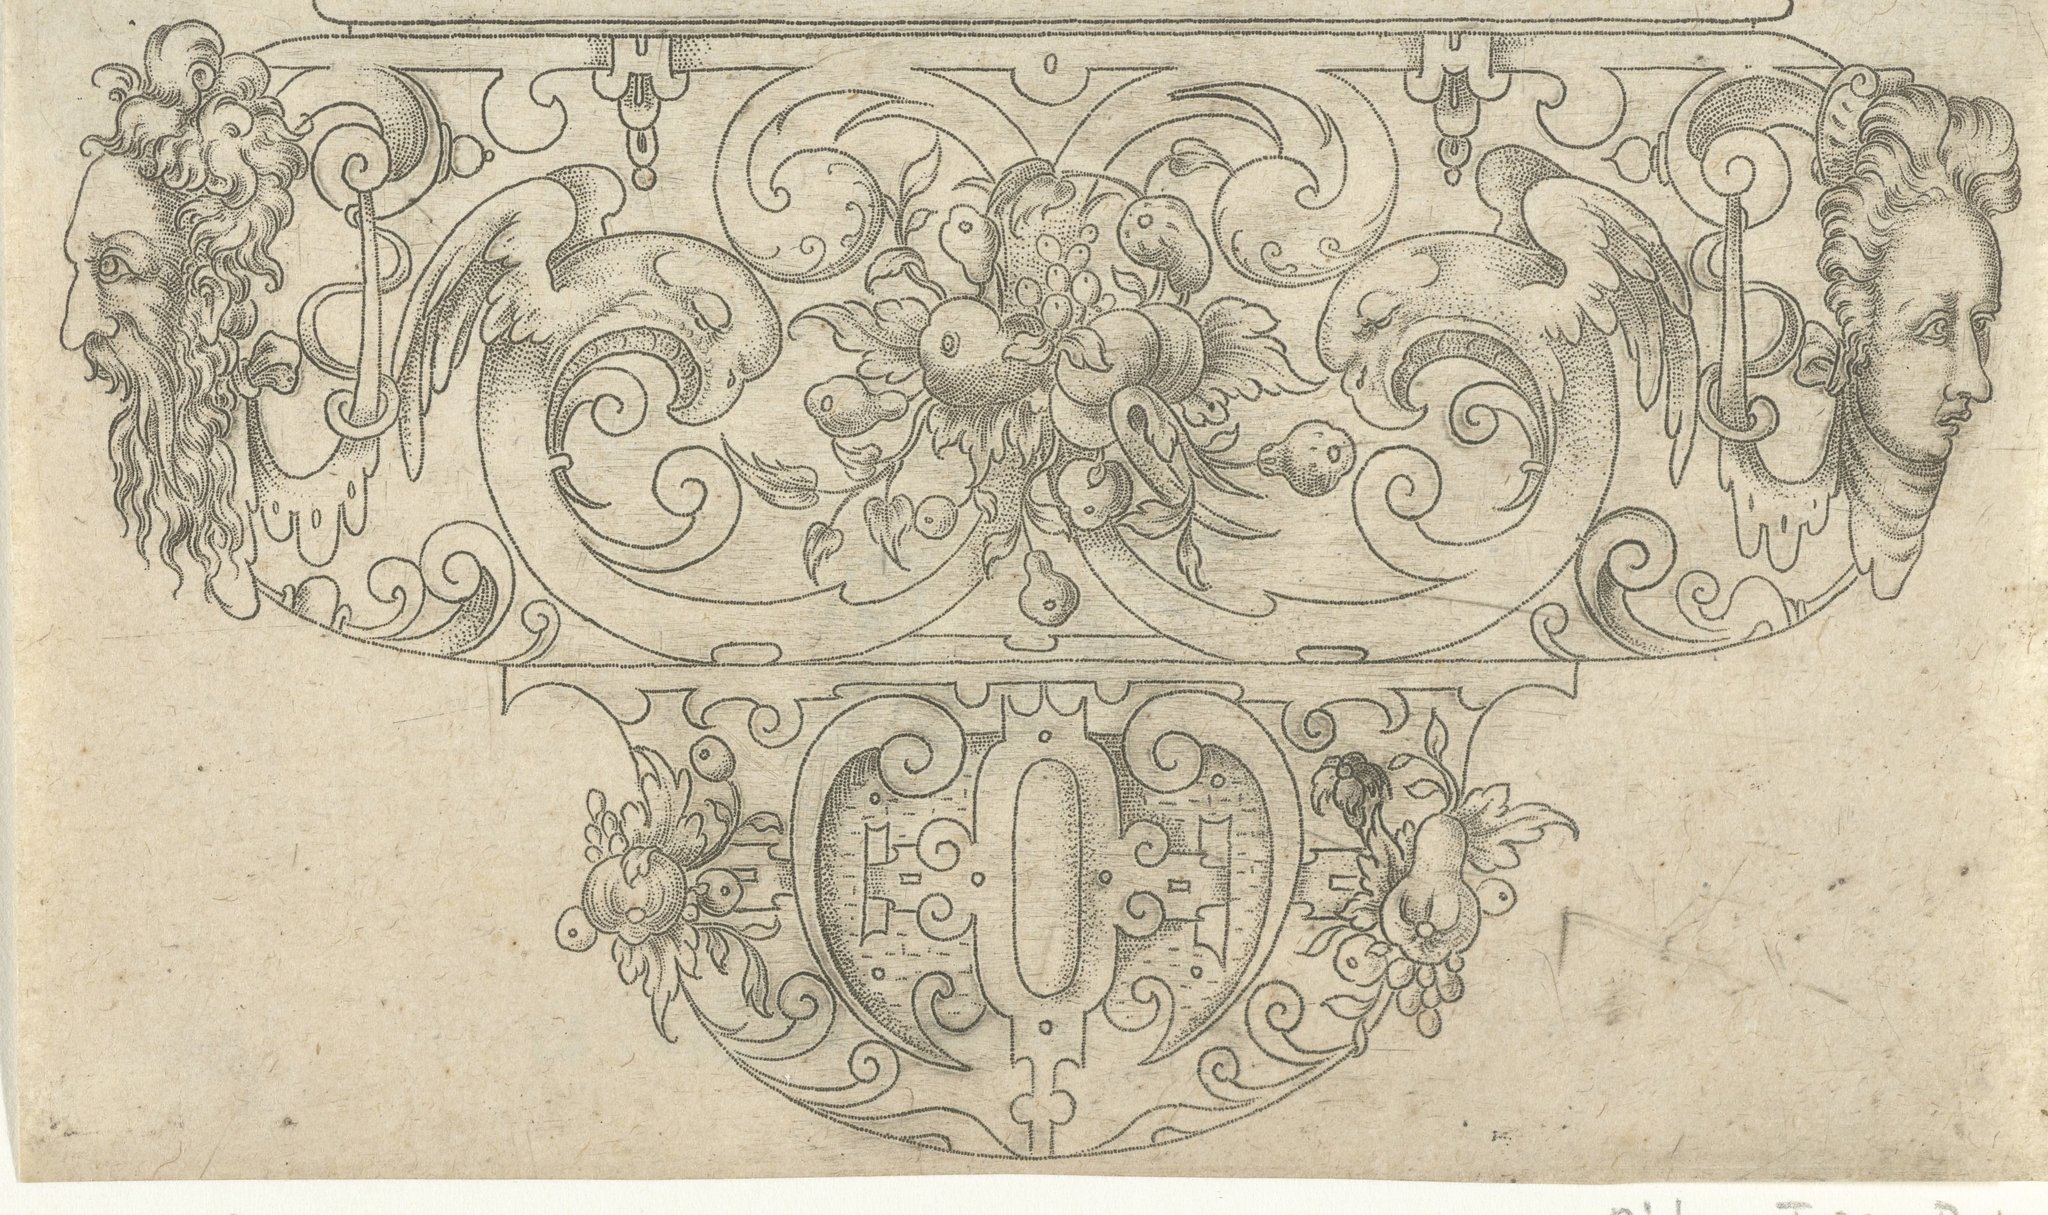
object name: ornament print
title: Veel schoene stucken om te drijven den Goudt smeden dienlijck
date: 1594-1635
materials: paper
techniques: engraving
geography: northern netherlands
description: Links en rechts hangt een mascaron. Tegenzijdige kopieën van de onder Orn Cat I-324.A vermelde serie. Titelblad en 14 deels genummerde bladen uit een serie van 25.